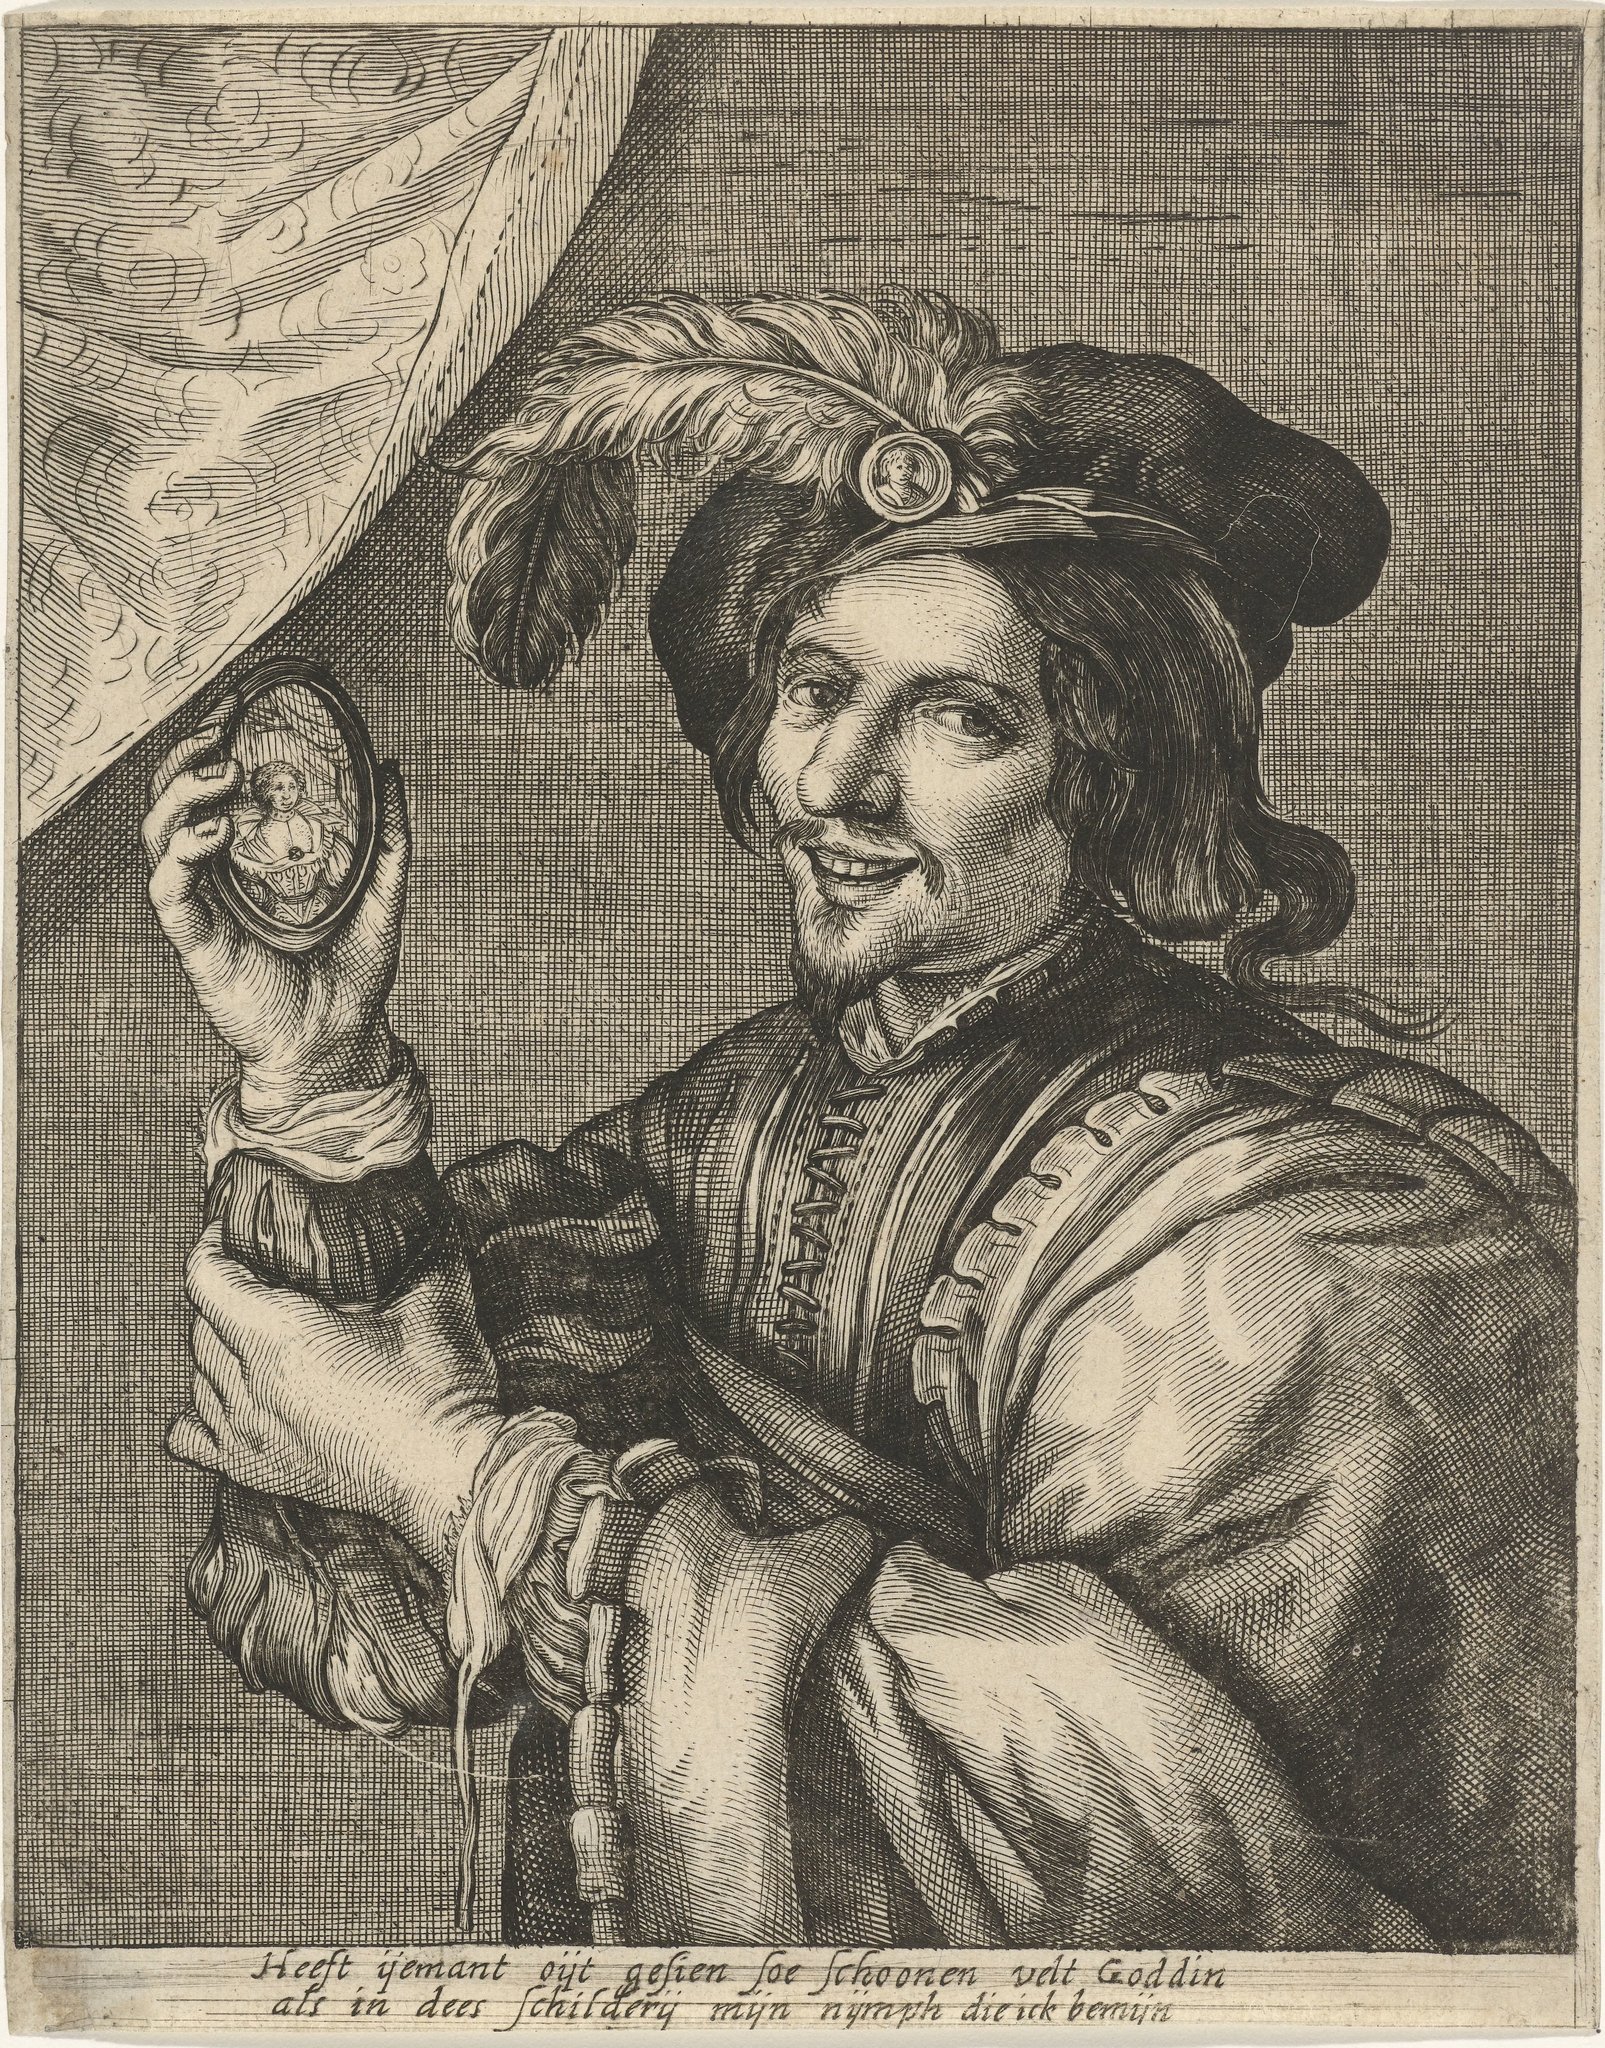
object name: print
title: Man met miniatuurportret in de hand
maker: Anonymous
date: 1615-1726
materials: paper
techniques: engraving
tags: painting (including book-illumination, miniature-painting)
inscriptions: inscription: ‘Franz Baumgartner 856’, poem: ‘Heeft ijemant oijt gesien soe schoonen velt Goddin/als in den schilderij mijn nijmph die ick bemin’, collector's mark: Lugt 2228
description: Jonge man met een muts met een veer op het hoofd. In de rechterhand houdt hij een miniatuur vrouwenportret.